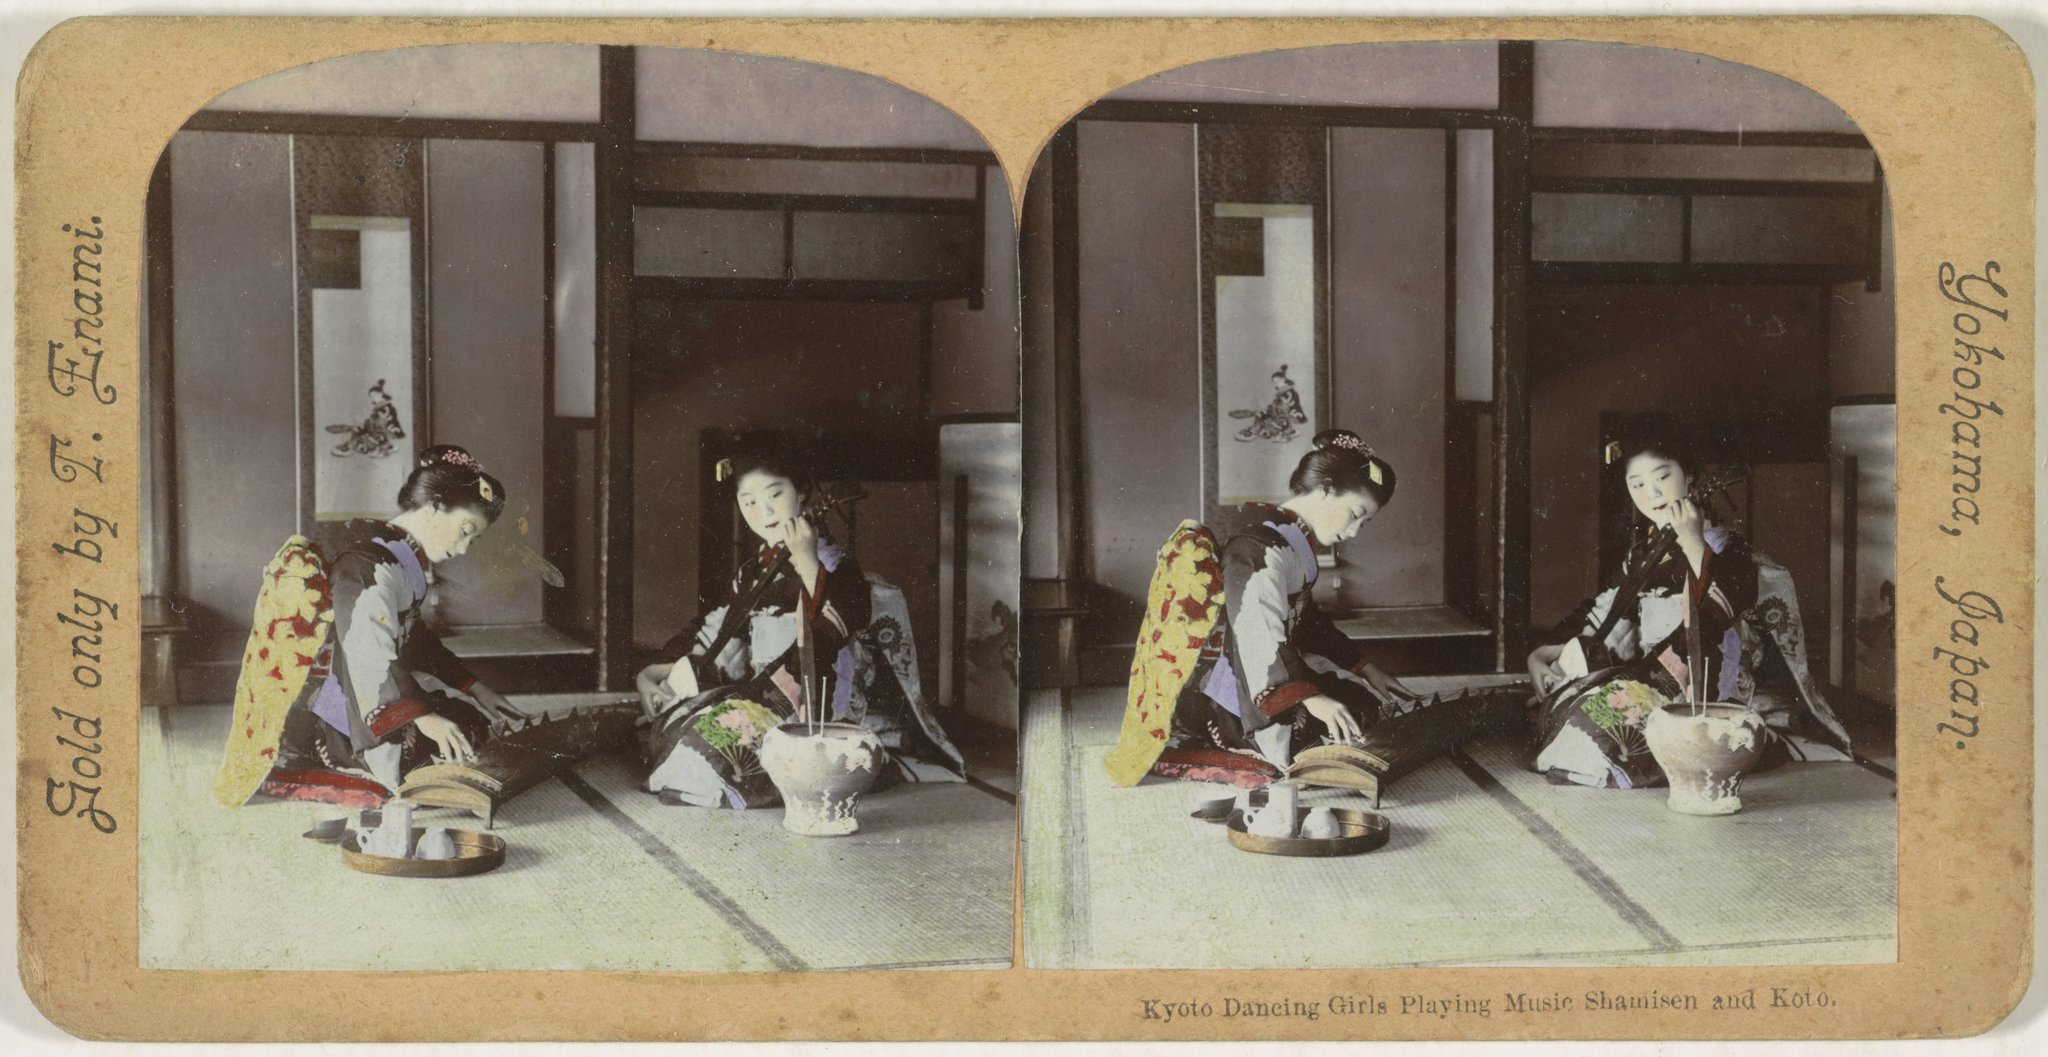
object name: stereograph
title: Kyoto Dancing Girls Playing Music Shamisen and Koto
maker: t. enami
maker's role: publisher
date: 1900-1907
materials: paper, cardboard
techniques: hand coloring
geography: yokohama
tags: string instruments (plucked), kyoto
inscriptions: number: ‘11’